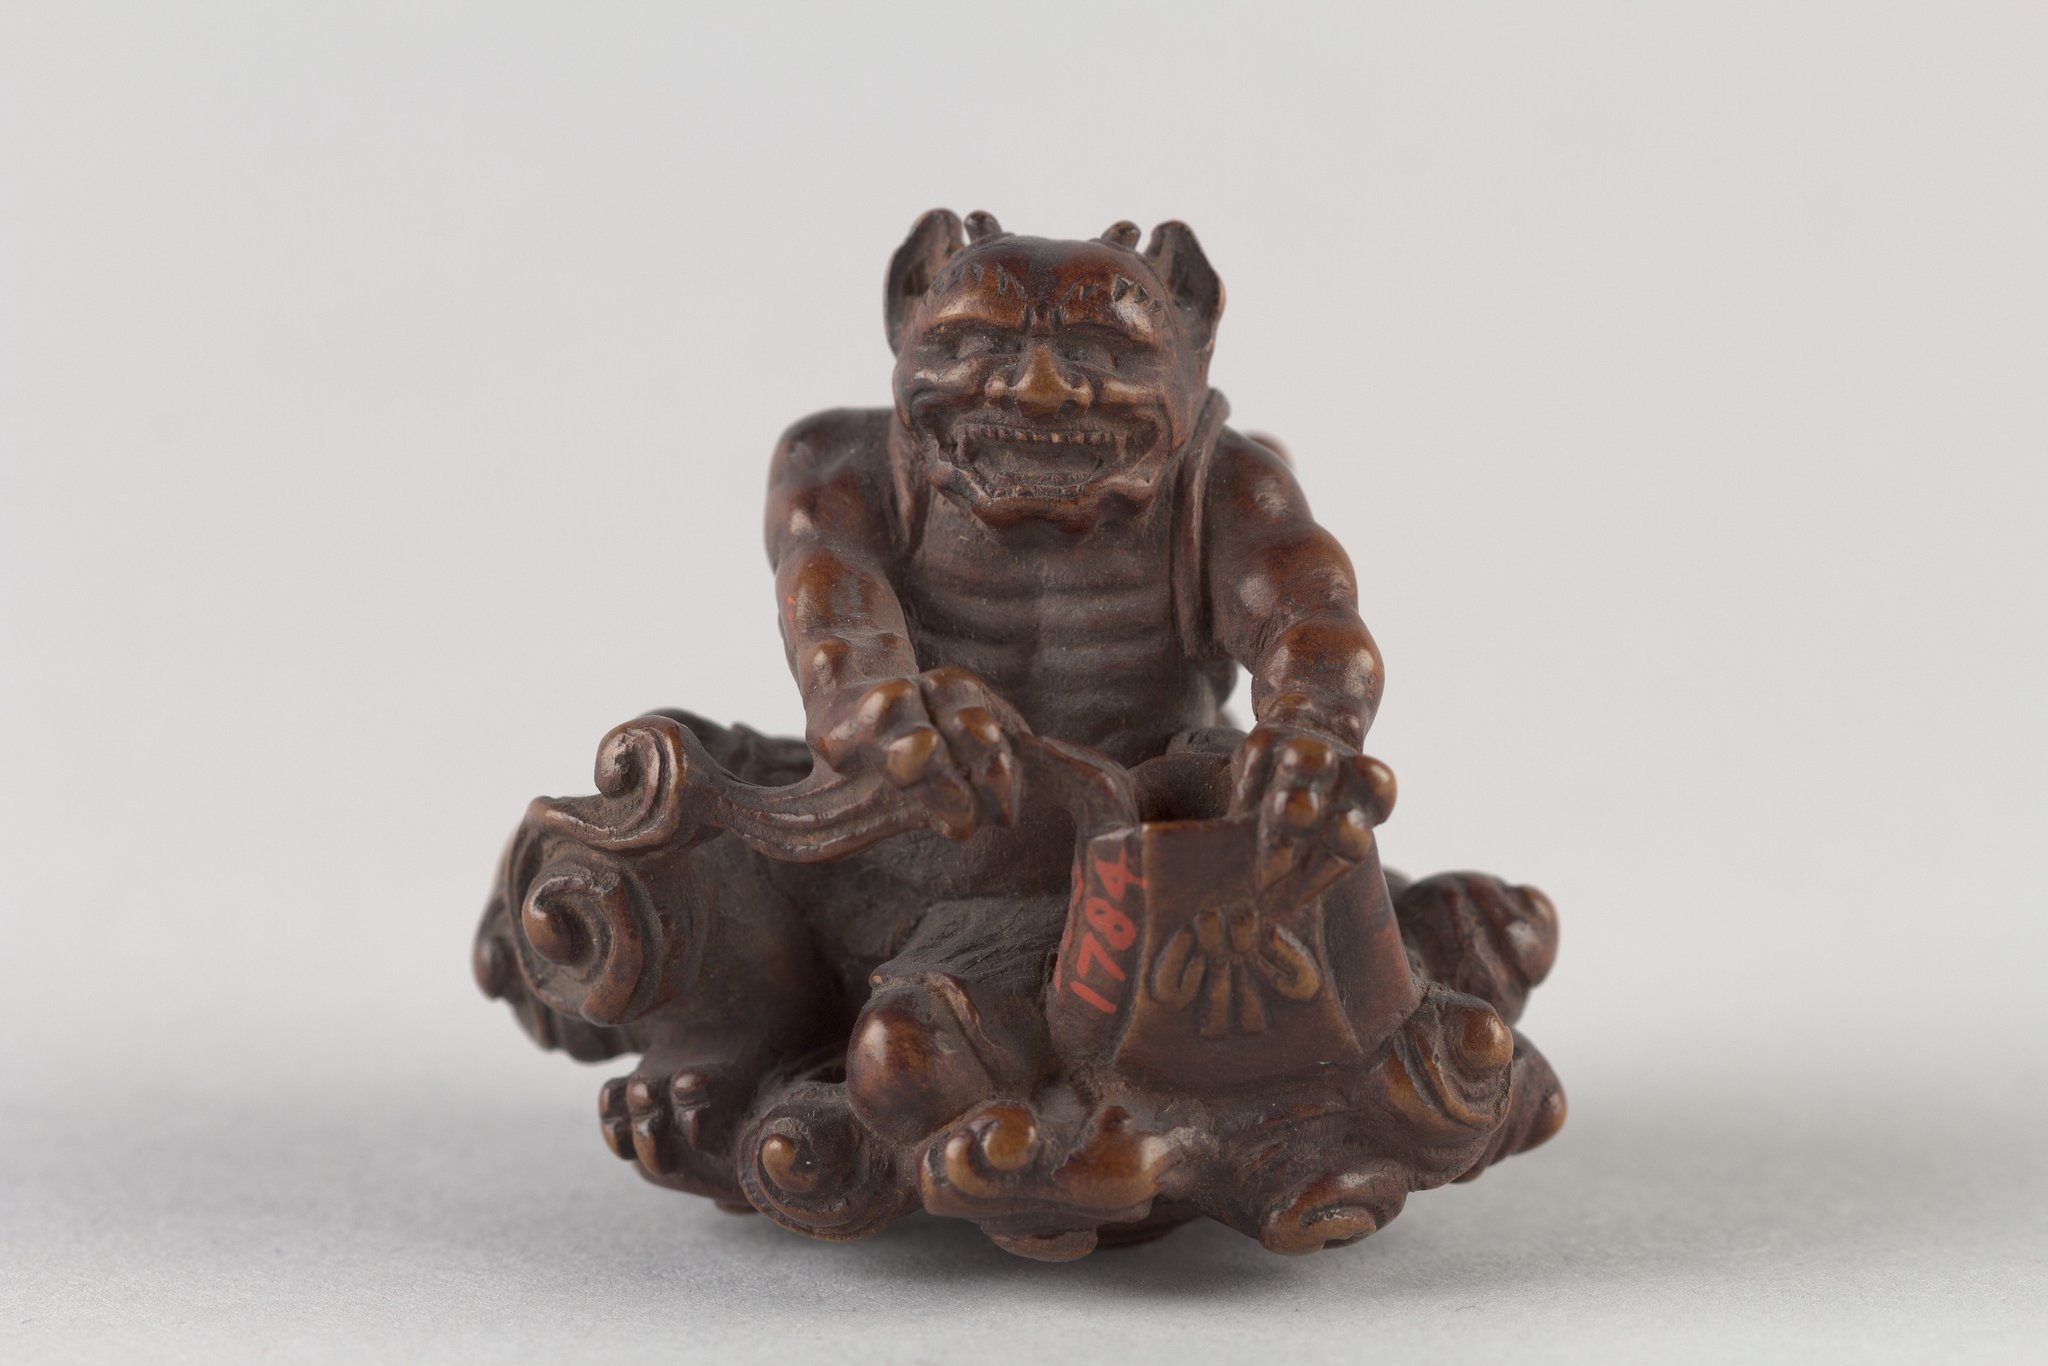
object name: netsuke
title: Netsuke of Demon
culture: japanese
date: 1701-1800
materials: wood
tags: demons